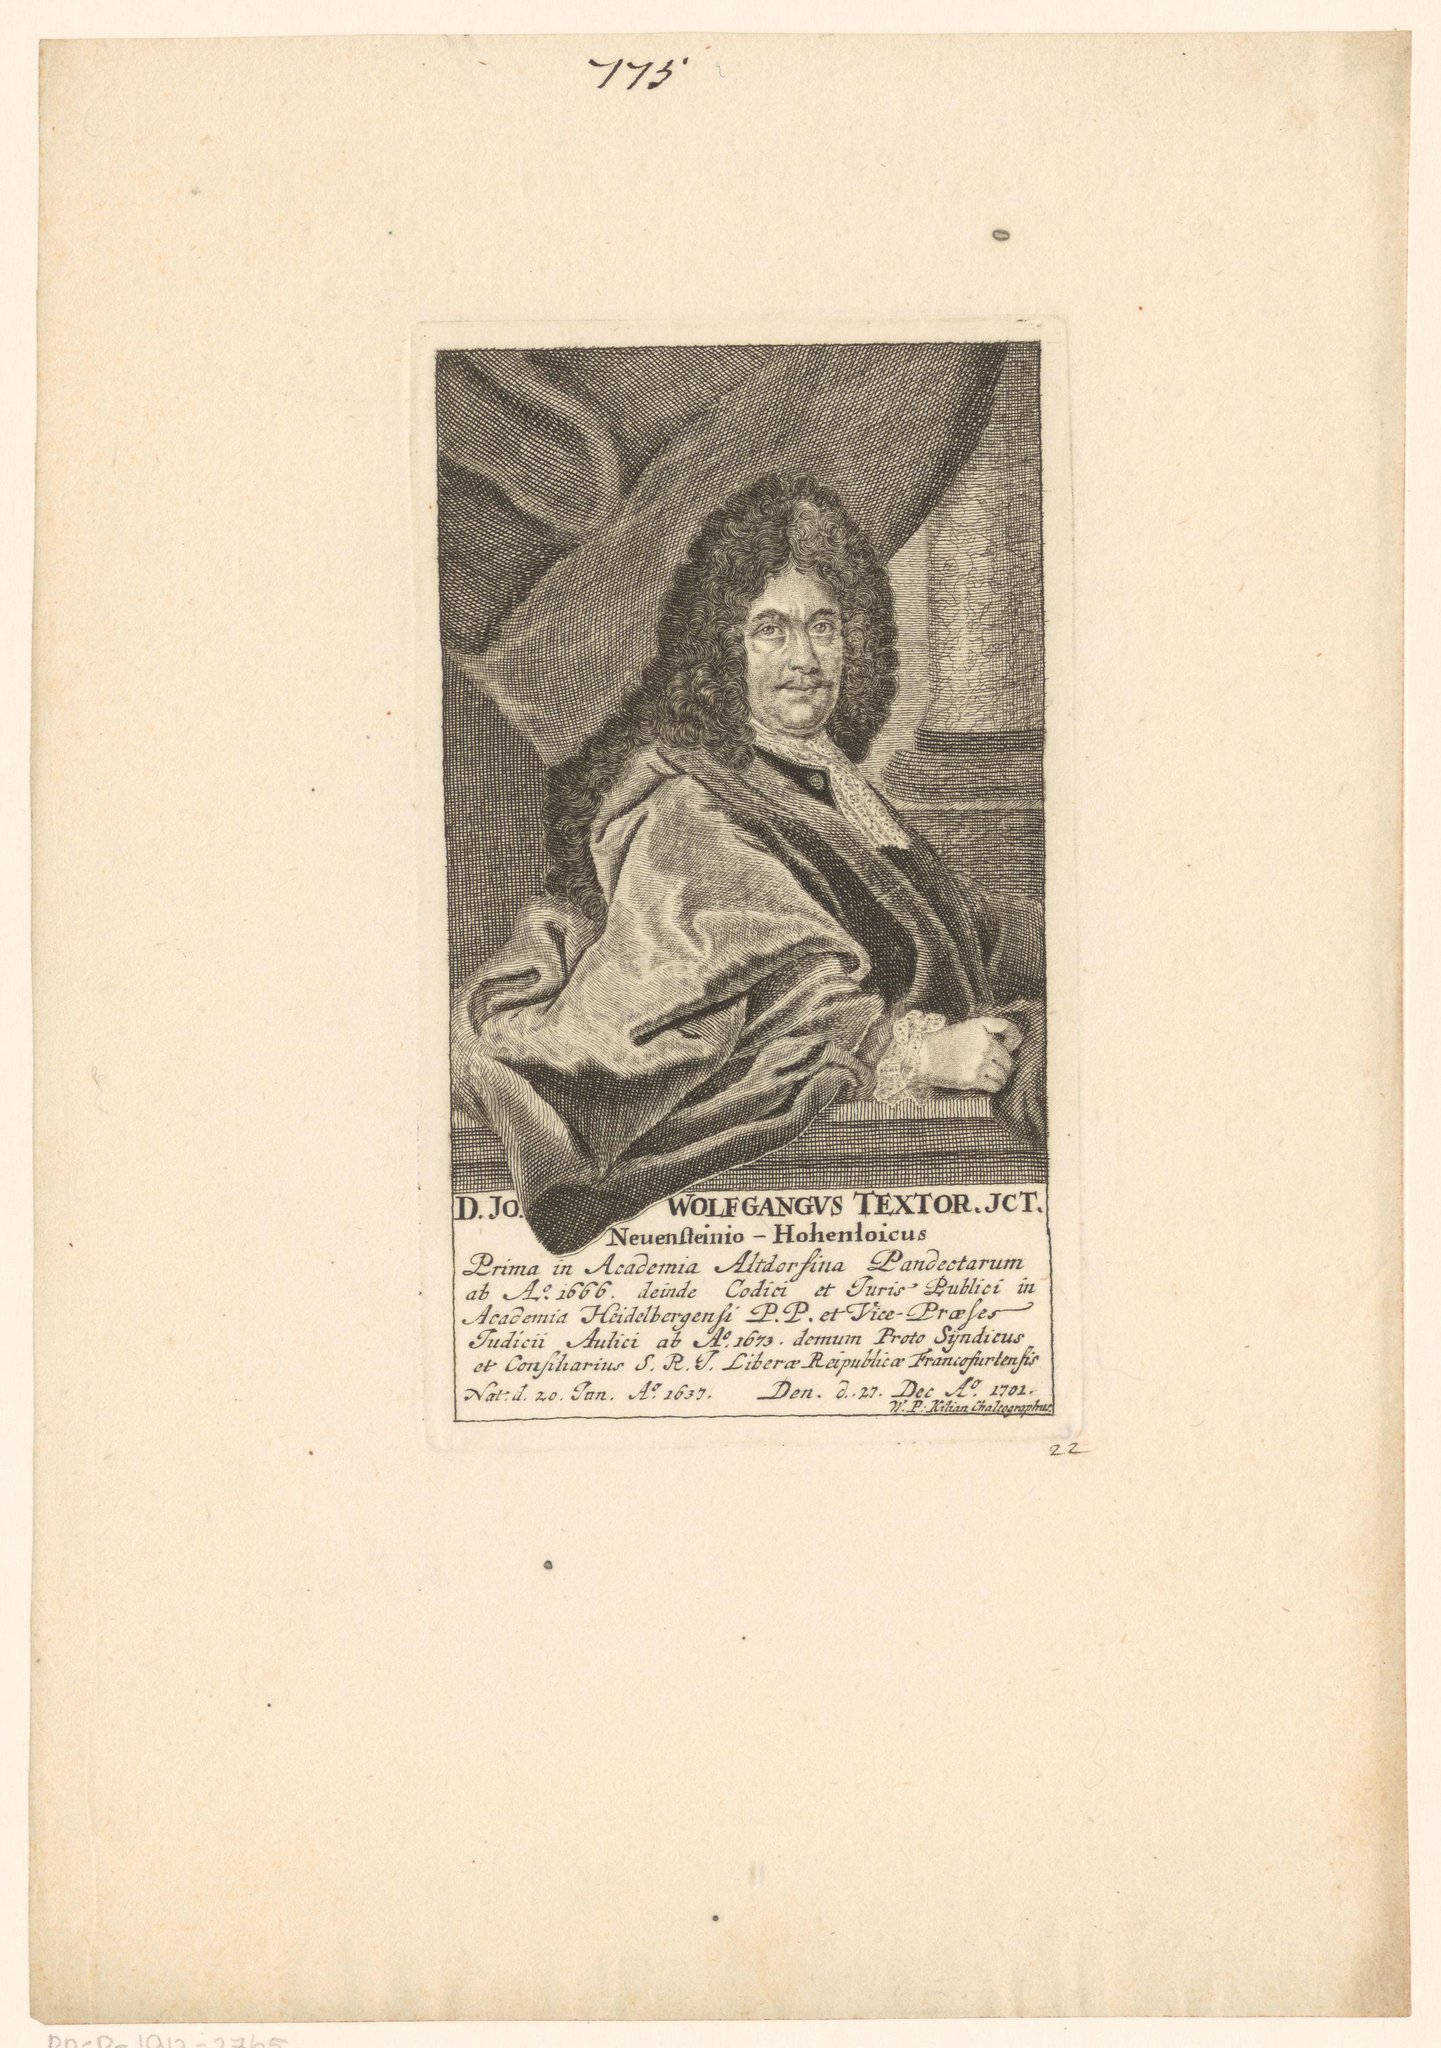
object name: print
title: Portret van Johann Wolfgang Textor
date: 1701-1732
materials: paper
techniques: engraving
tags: further education (+ portrait of teacher, professor), historical persons, lawyer, attorney at law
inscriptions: number: ‘22’, collector's mark: Lugt 2228